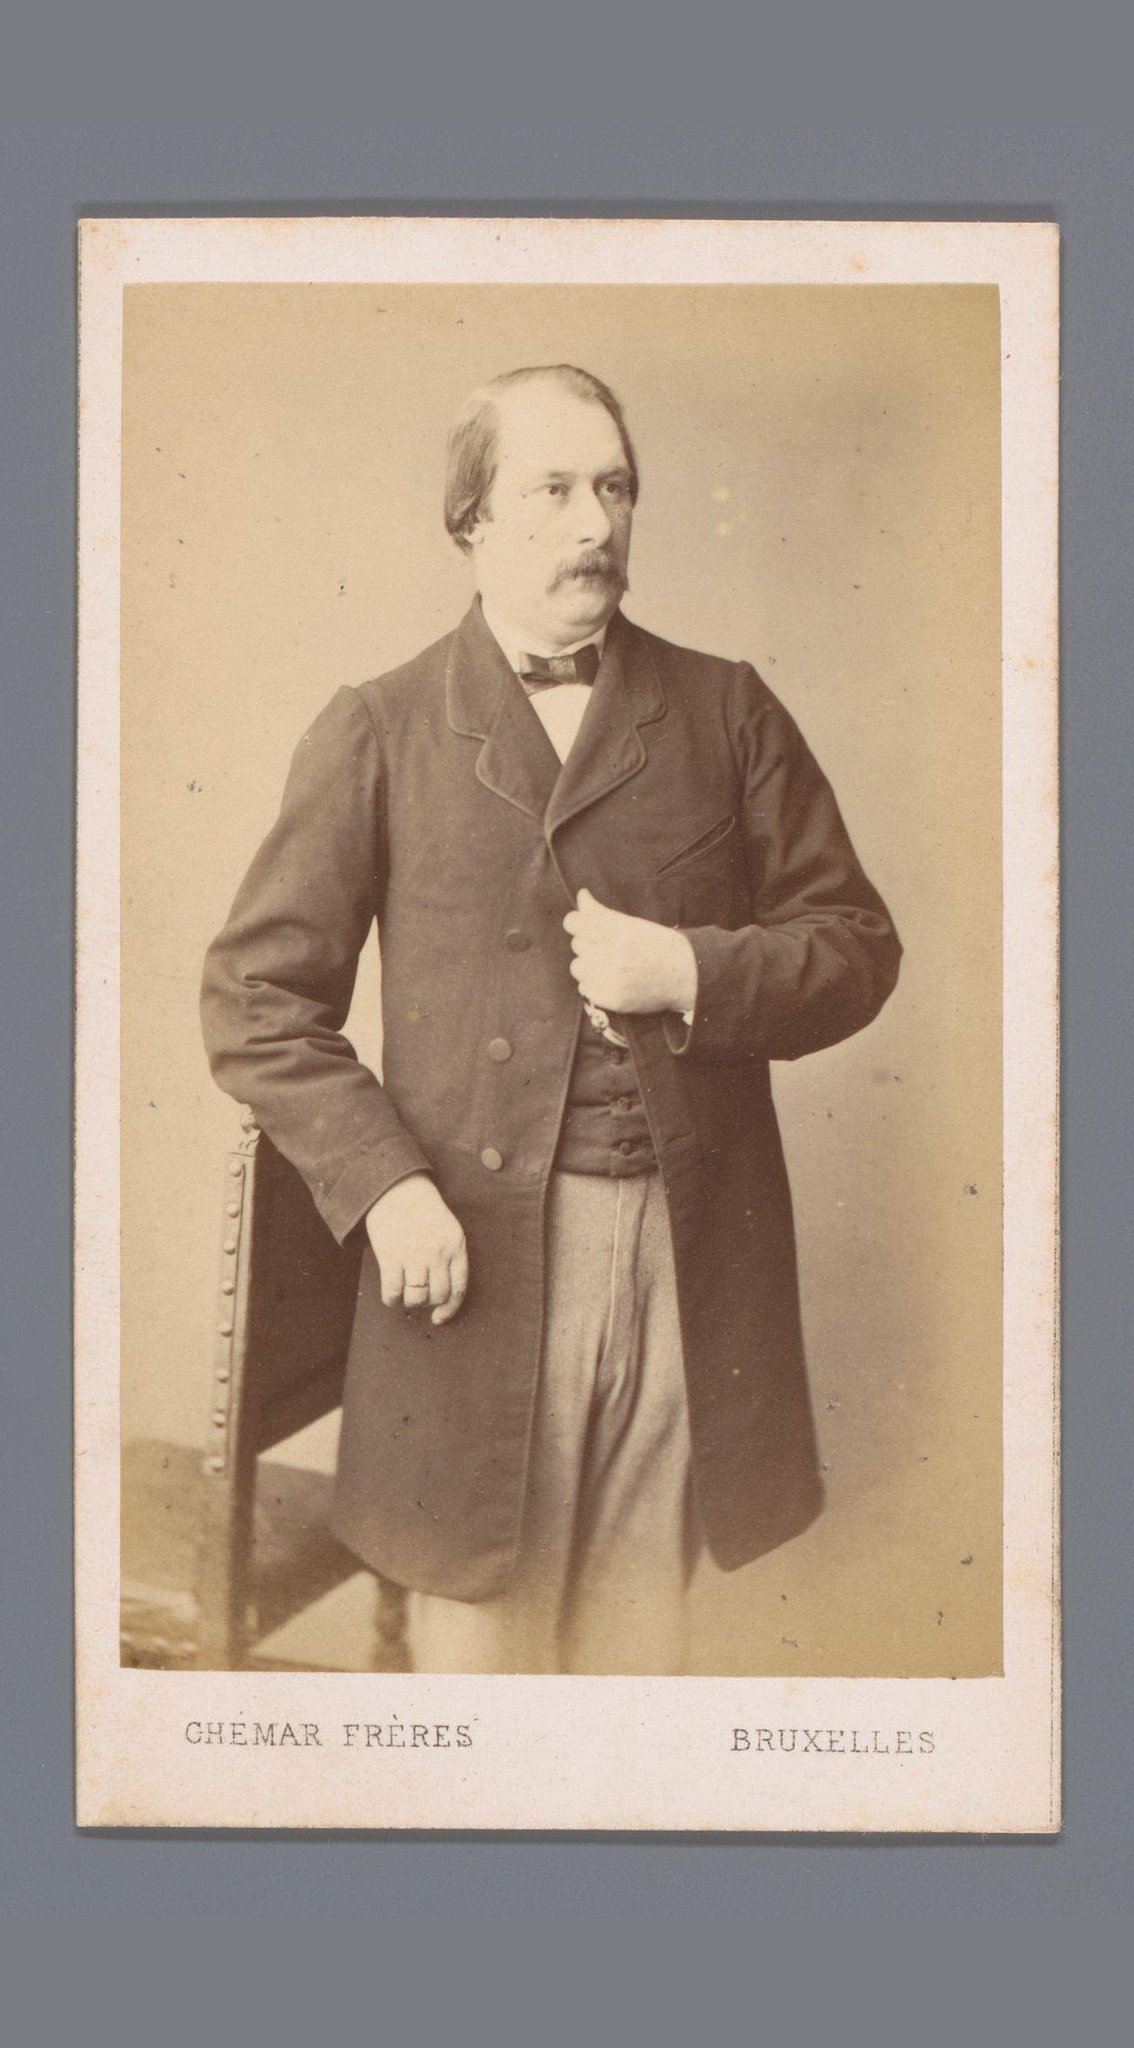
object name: photograph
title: Portret van een onbekende man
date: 1859-1894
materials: cardboard, paper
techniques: albumen print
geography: brussels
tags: adult man, anonymous historical person portrayed, brussels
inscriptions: inscription: ‘Ghémar Frères Bruxelles’, inscription: ‘Les Chlichés étant conservés indéfiniment/ on peut toujours se procurer de nouvelles/ épreuves de Cartes & Portraits sans reposer’, inscription: ‘Ghémar Frères/ Photographes du roi/ 27, Rue de l'Ecuyer, 27./ Entrée par la porte cochère/ Bruxelles’